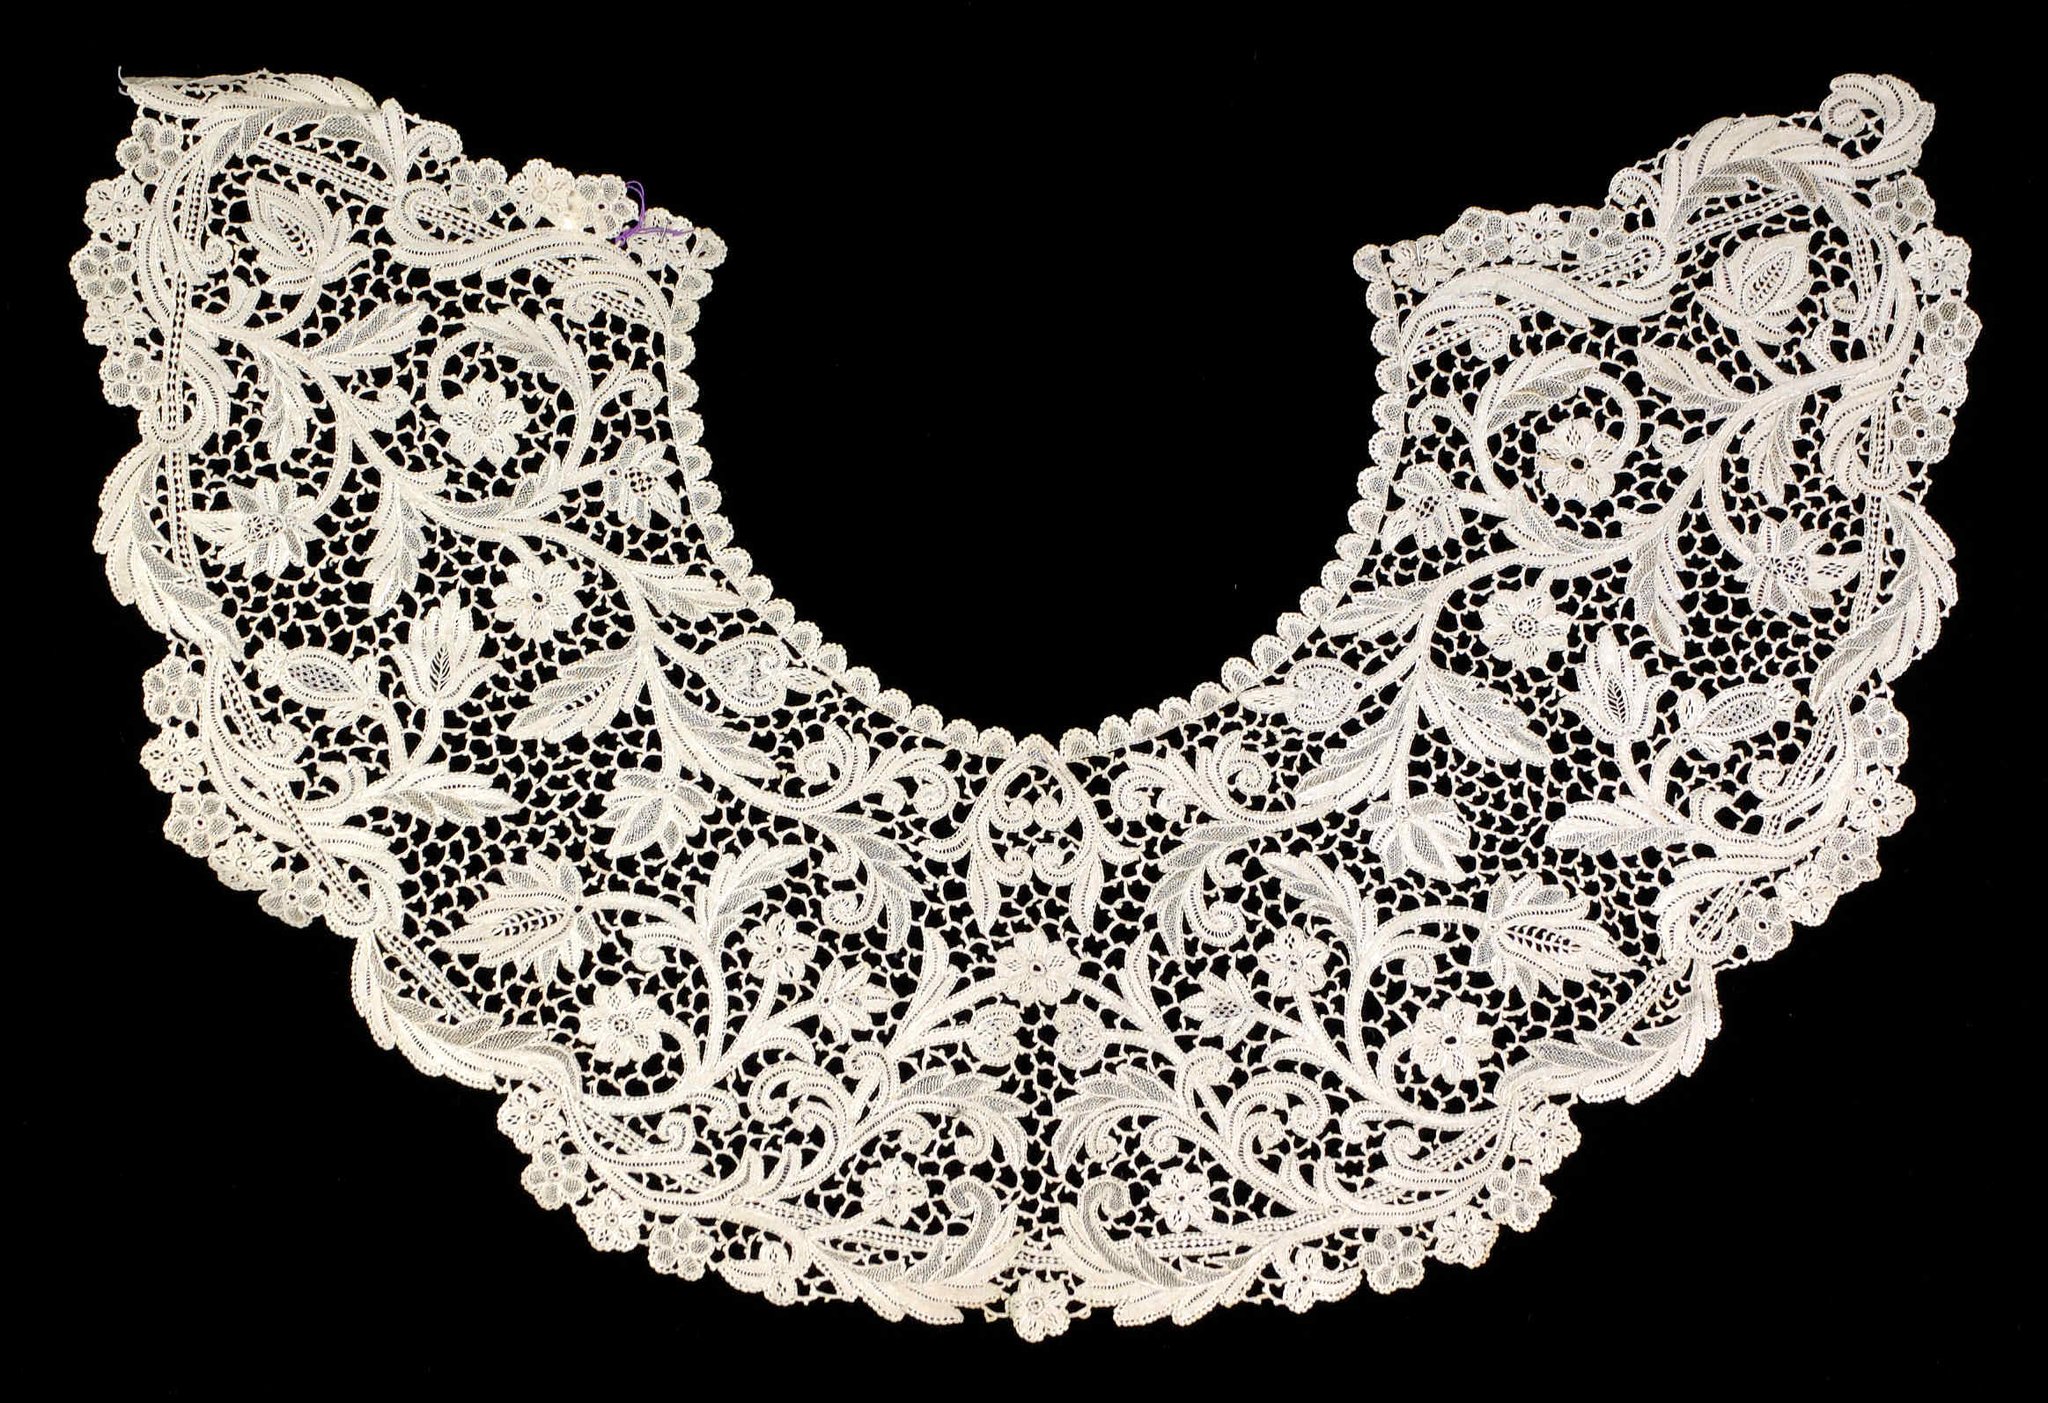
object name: collar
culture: italian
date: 1890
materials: linen